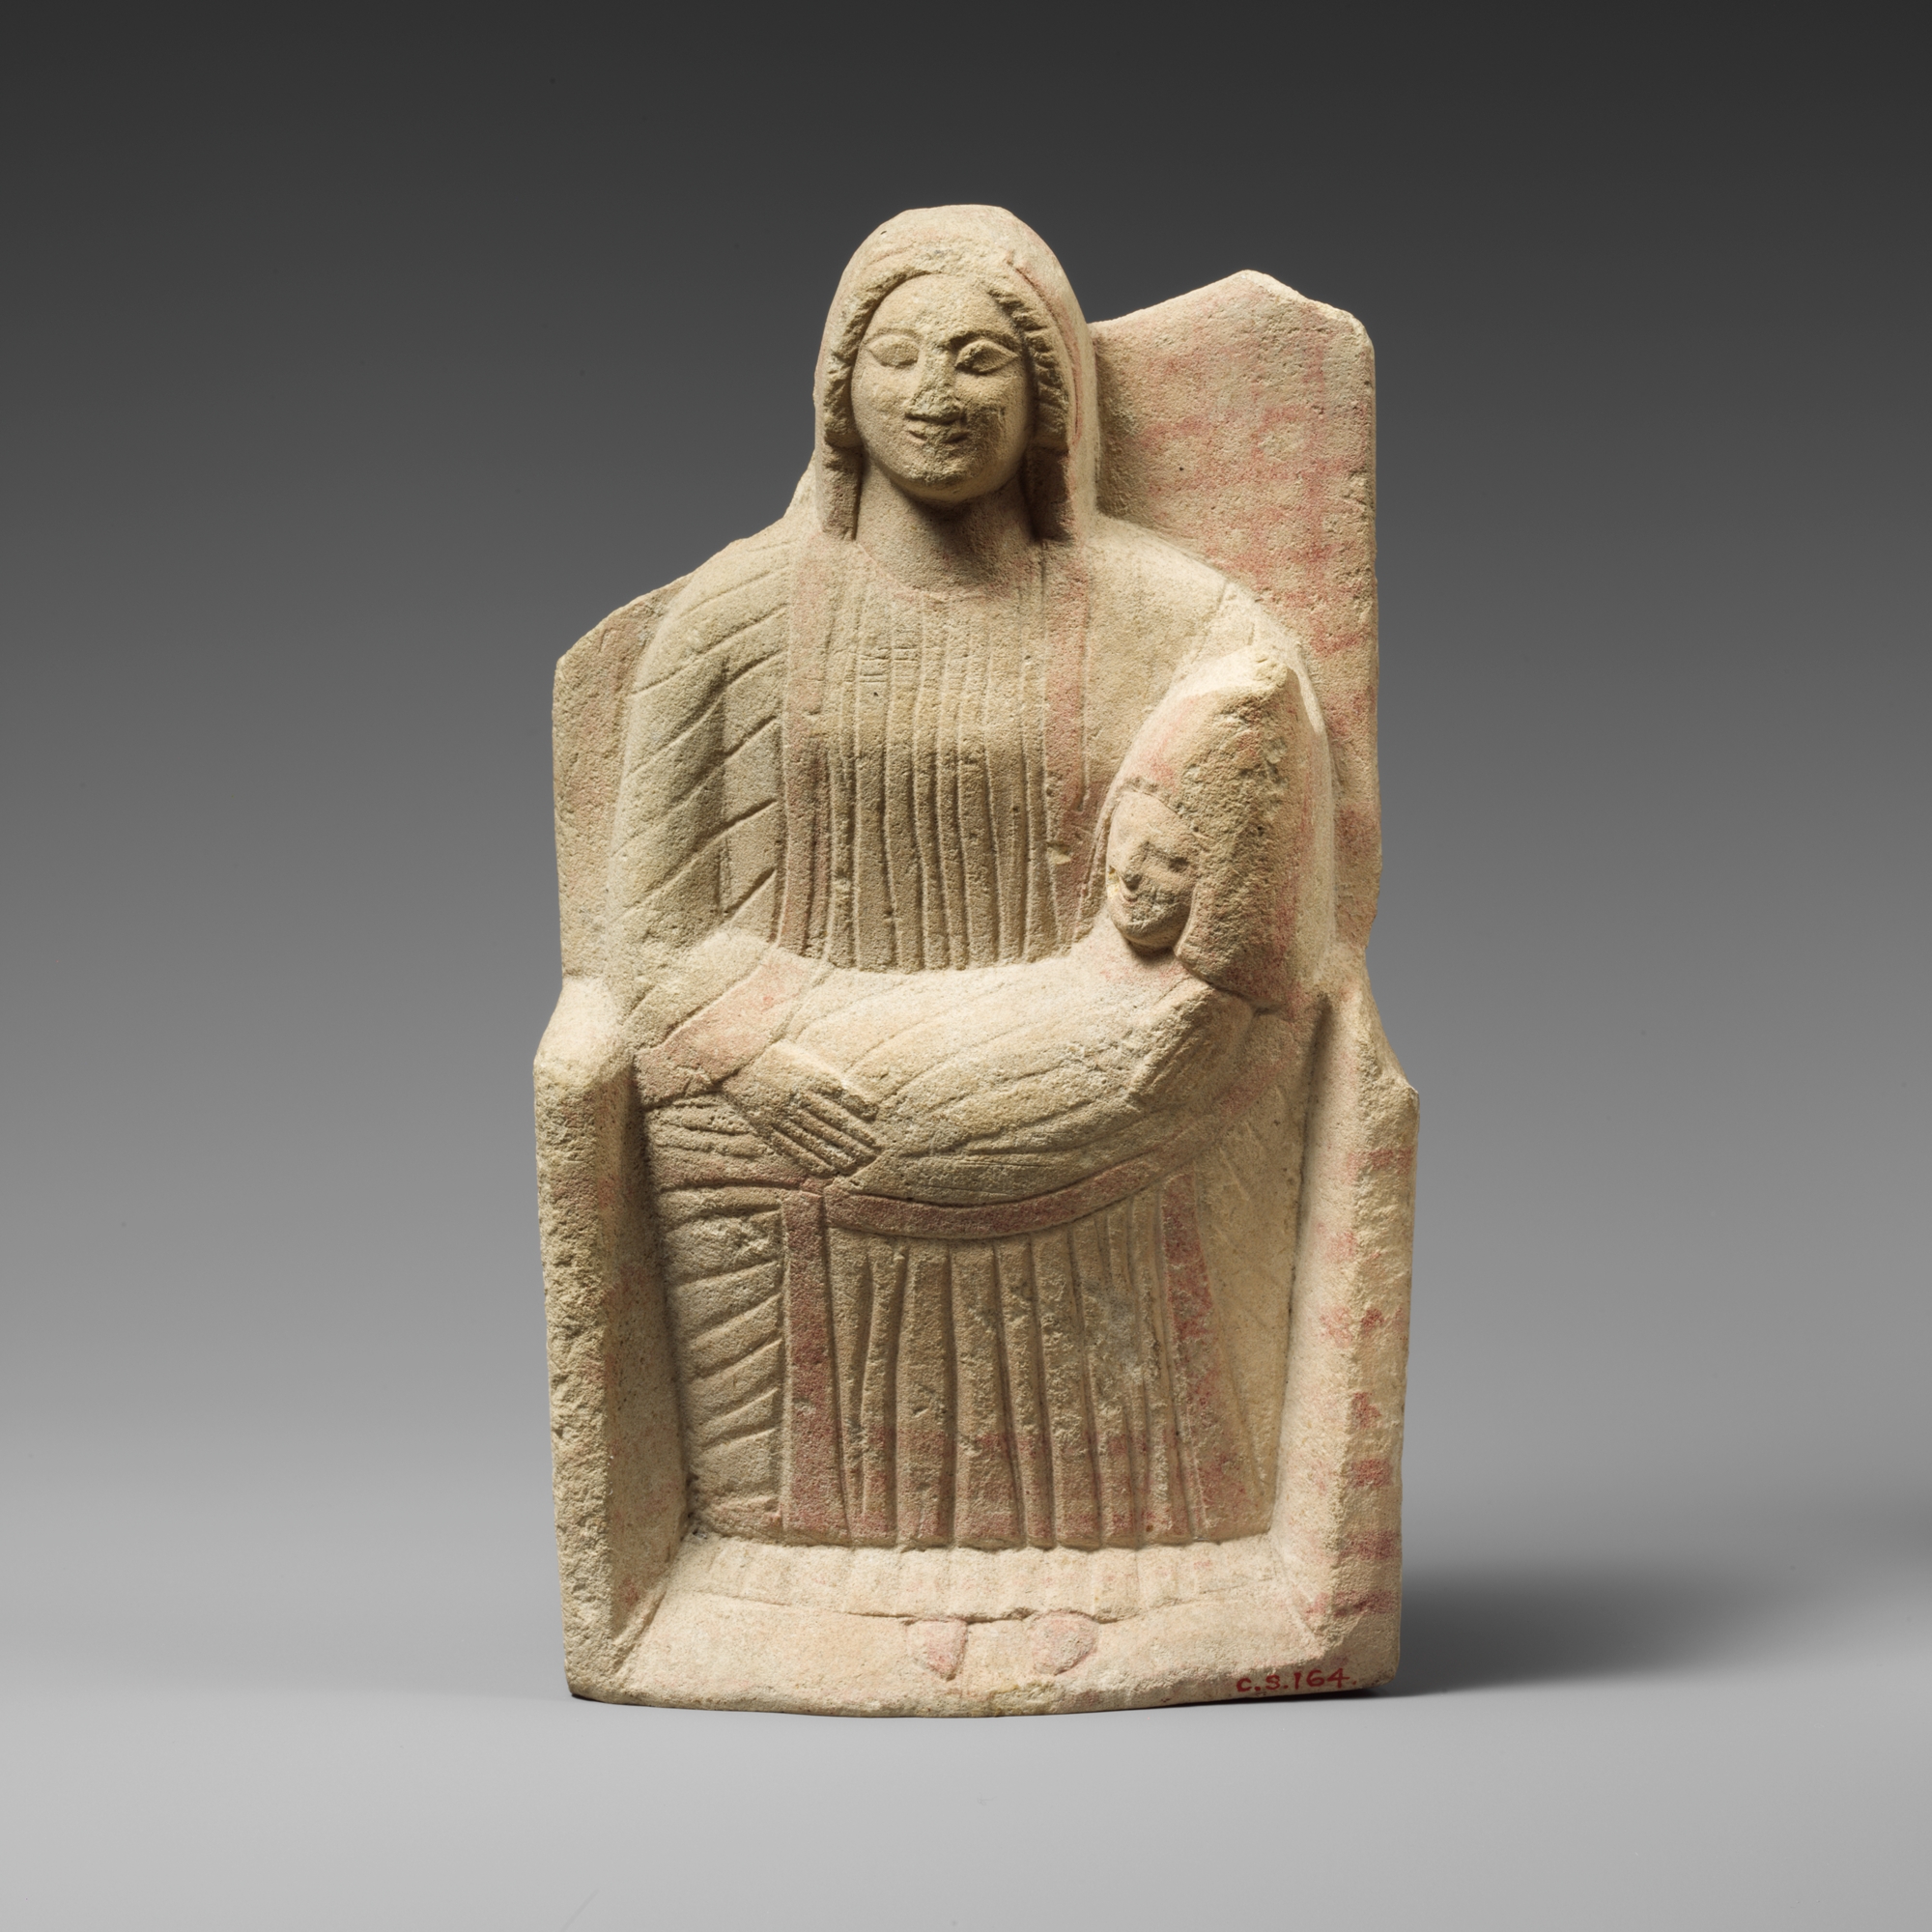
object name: statuette of a woman nursing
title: Seated limestone kourotrophos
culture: cypriot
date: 450-401 BCE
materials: limestone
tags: infants,women